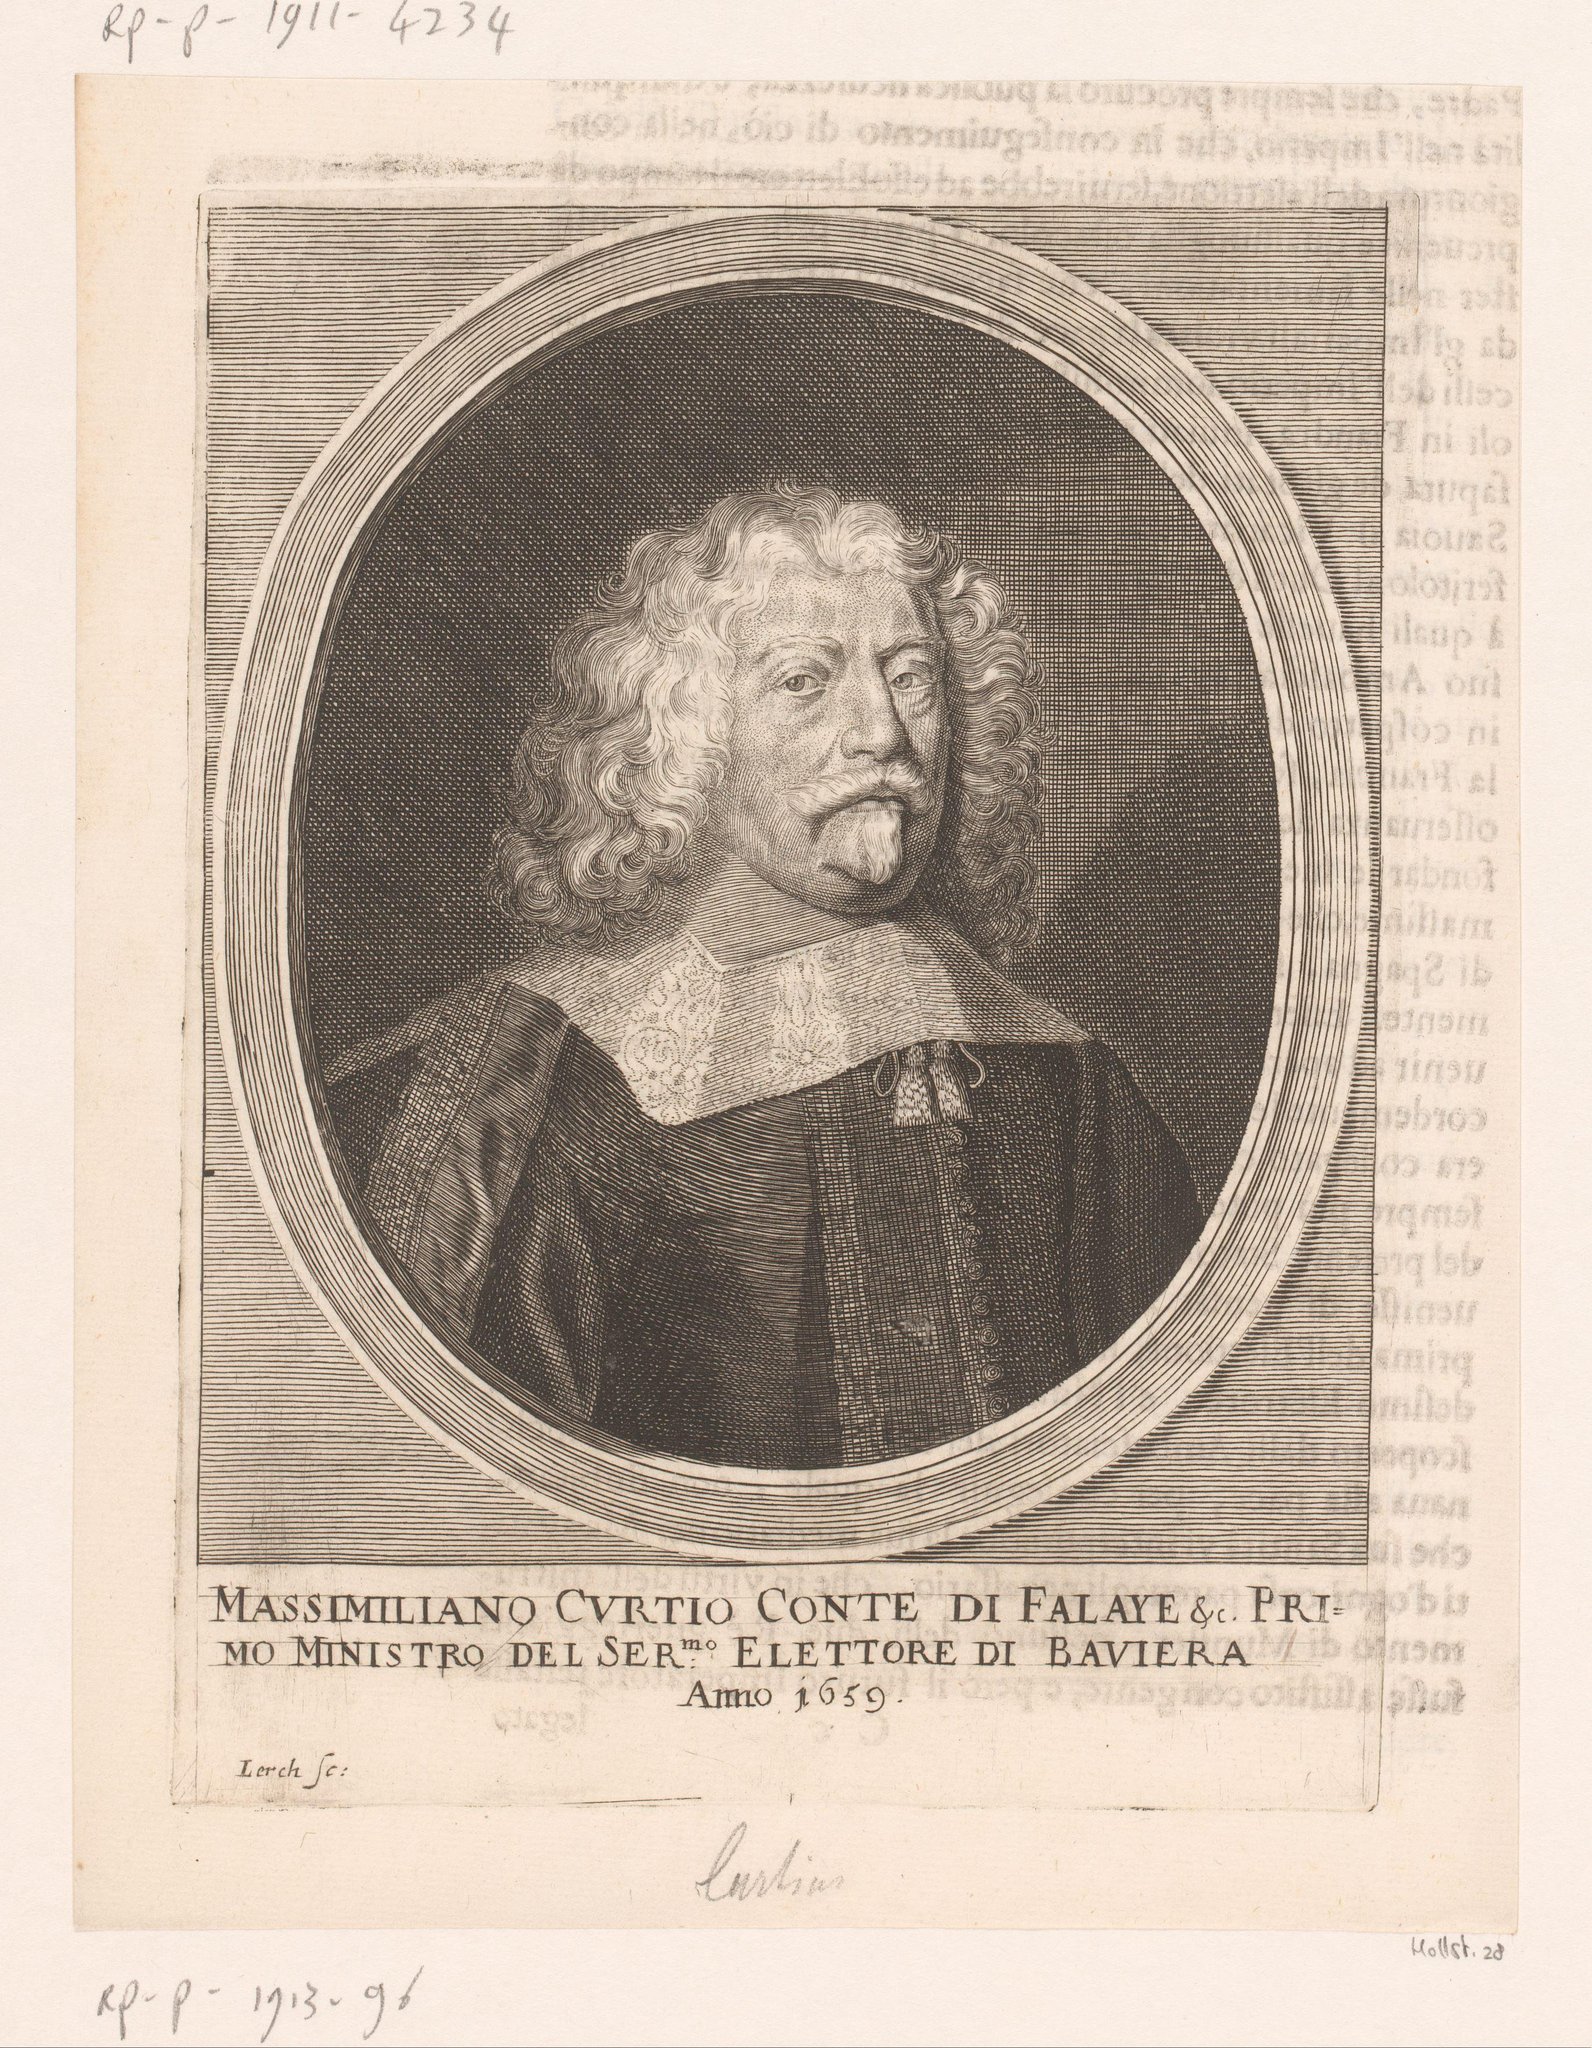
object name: print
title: Portret van Maximilian Curtz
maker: johann martin lerch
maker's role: print maker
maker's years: 1643-1693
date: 1659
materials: paper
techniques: engraving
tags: historical persons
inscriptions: collector's mark: Lugt 2228